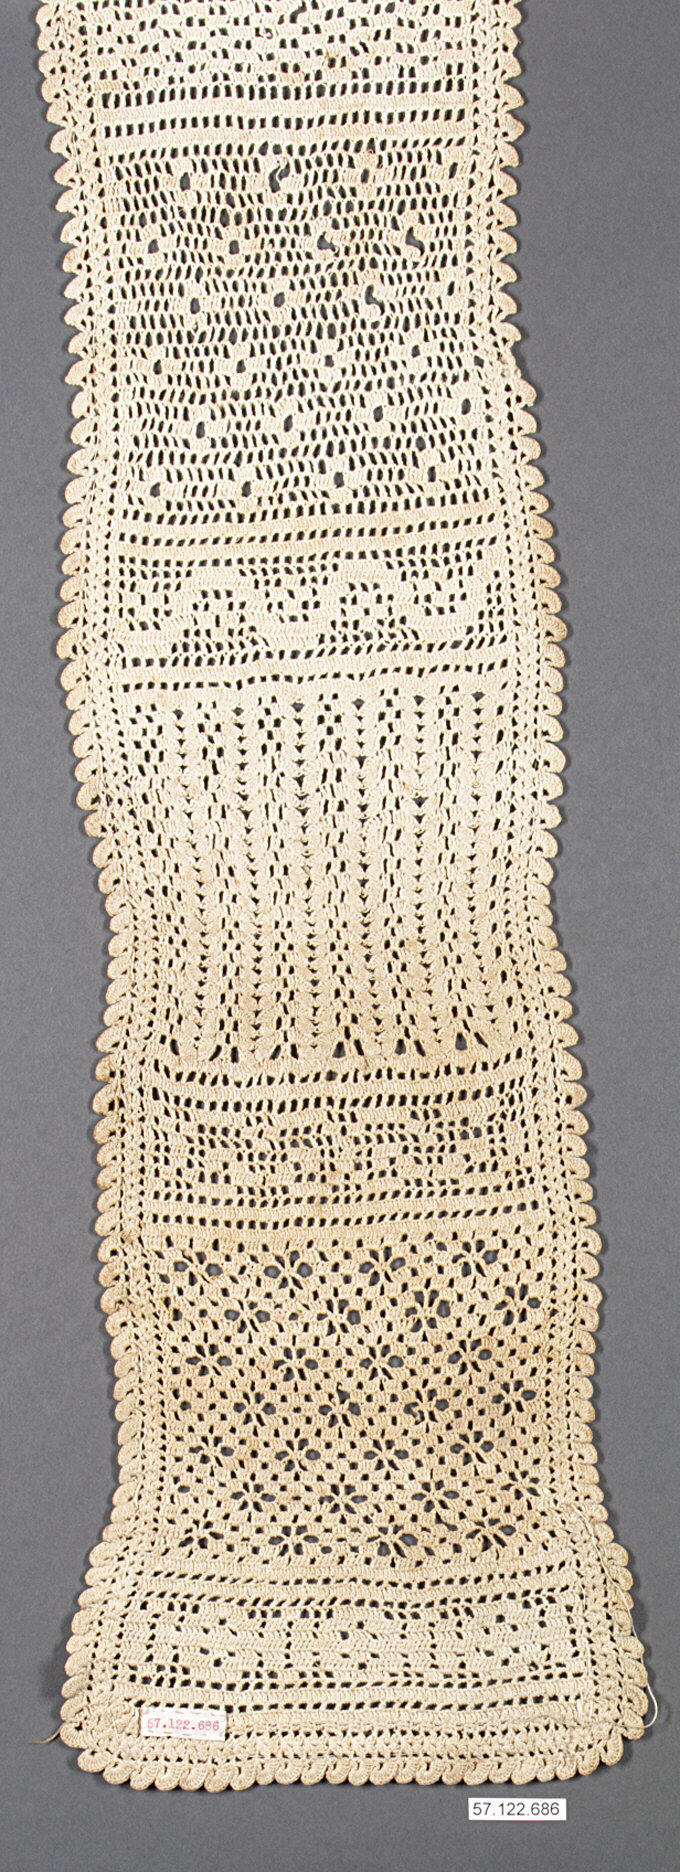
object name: sampler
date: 1801-1900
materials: cotton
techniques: crochet